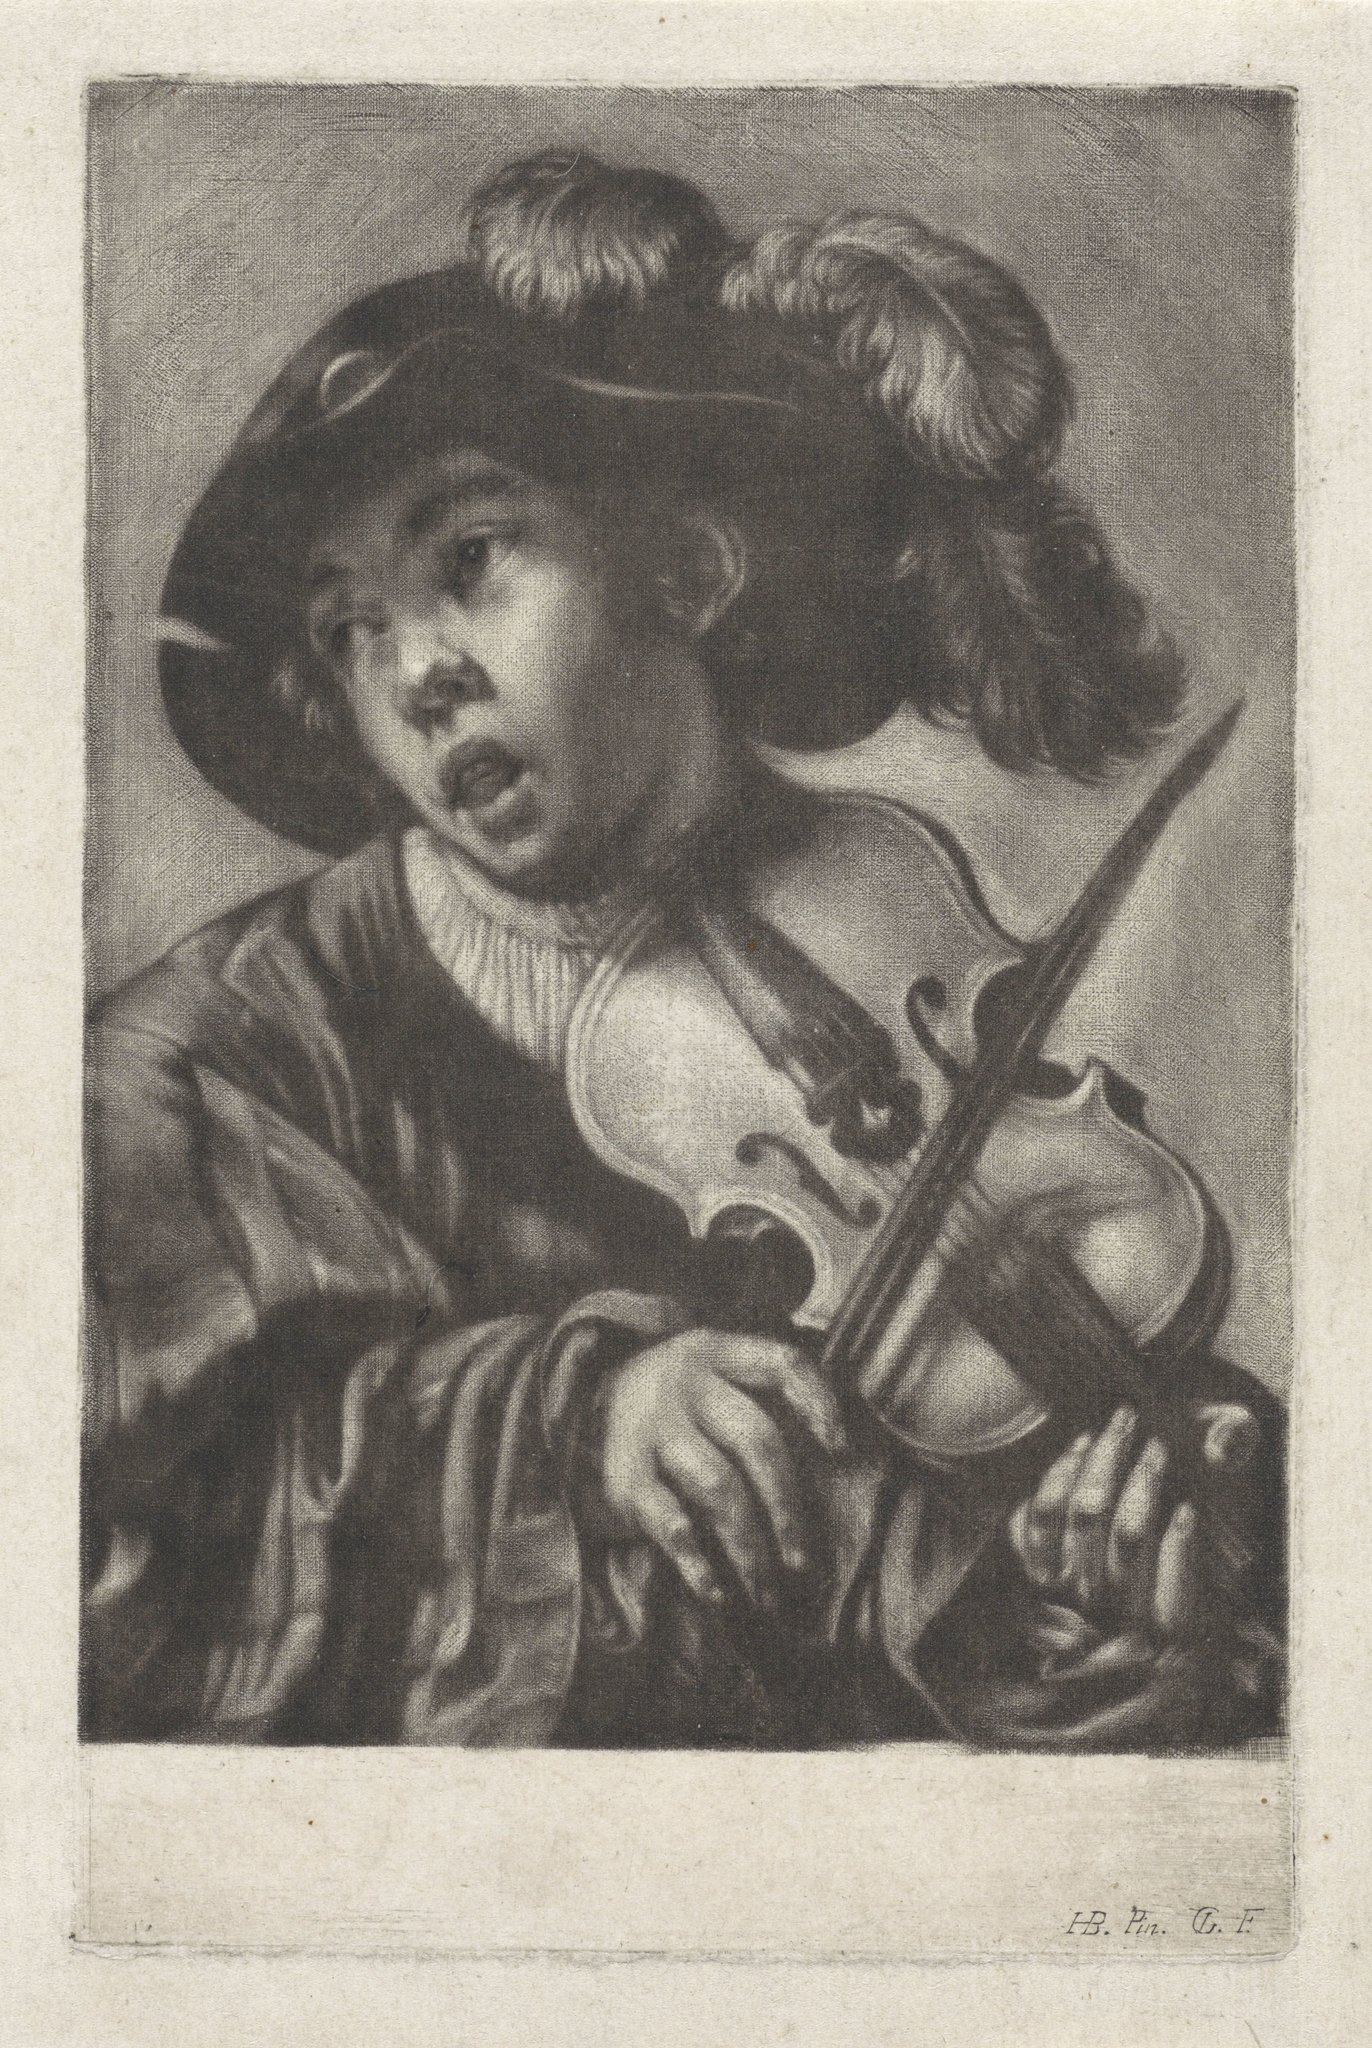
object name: print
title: Portret van Daniel Boon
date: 1667-1718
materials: paper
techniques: engraving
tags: historical persons, violin, fiddle, portrait of a musician, portrait of composer, portrait, self-portrait of painter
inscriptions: collector's mark: Lugt 2233, collector's mark: Lugt 2228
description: De schilder en musicus Daniel Boon als violist. Hij draagt een hoed met veren.